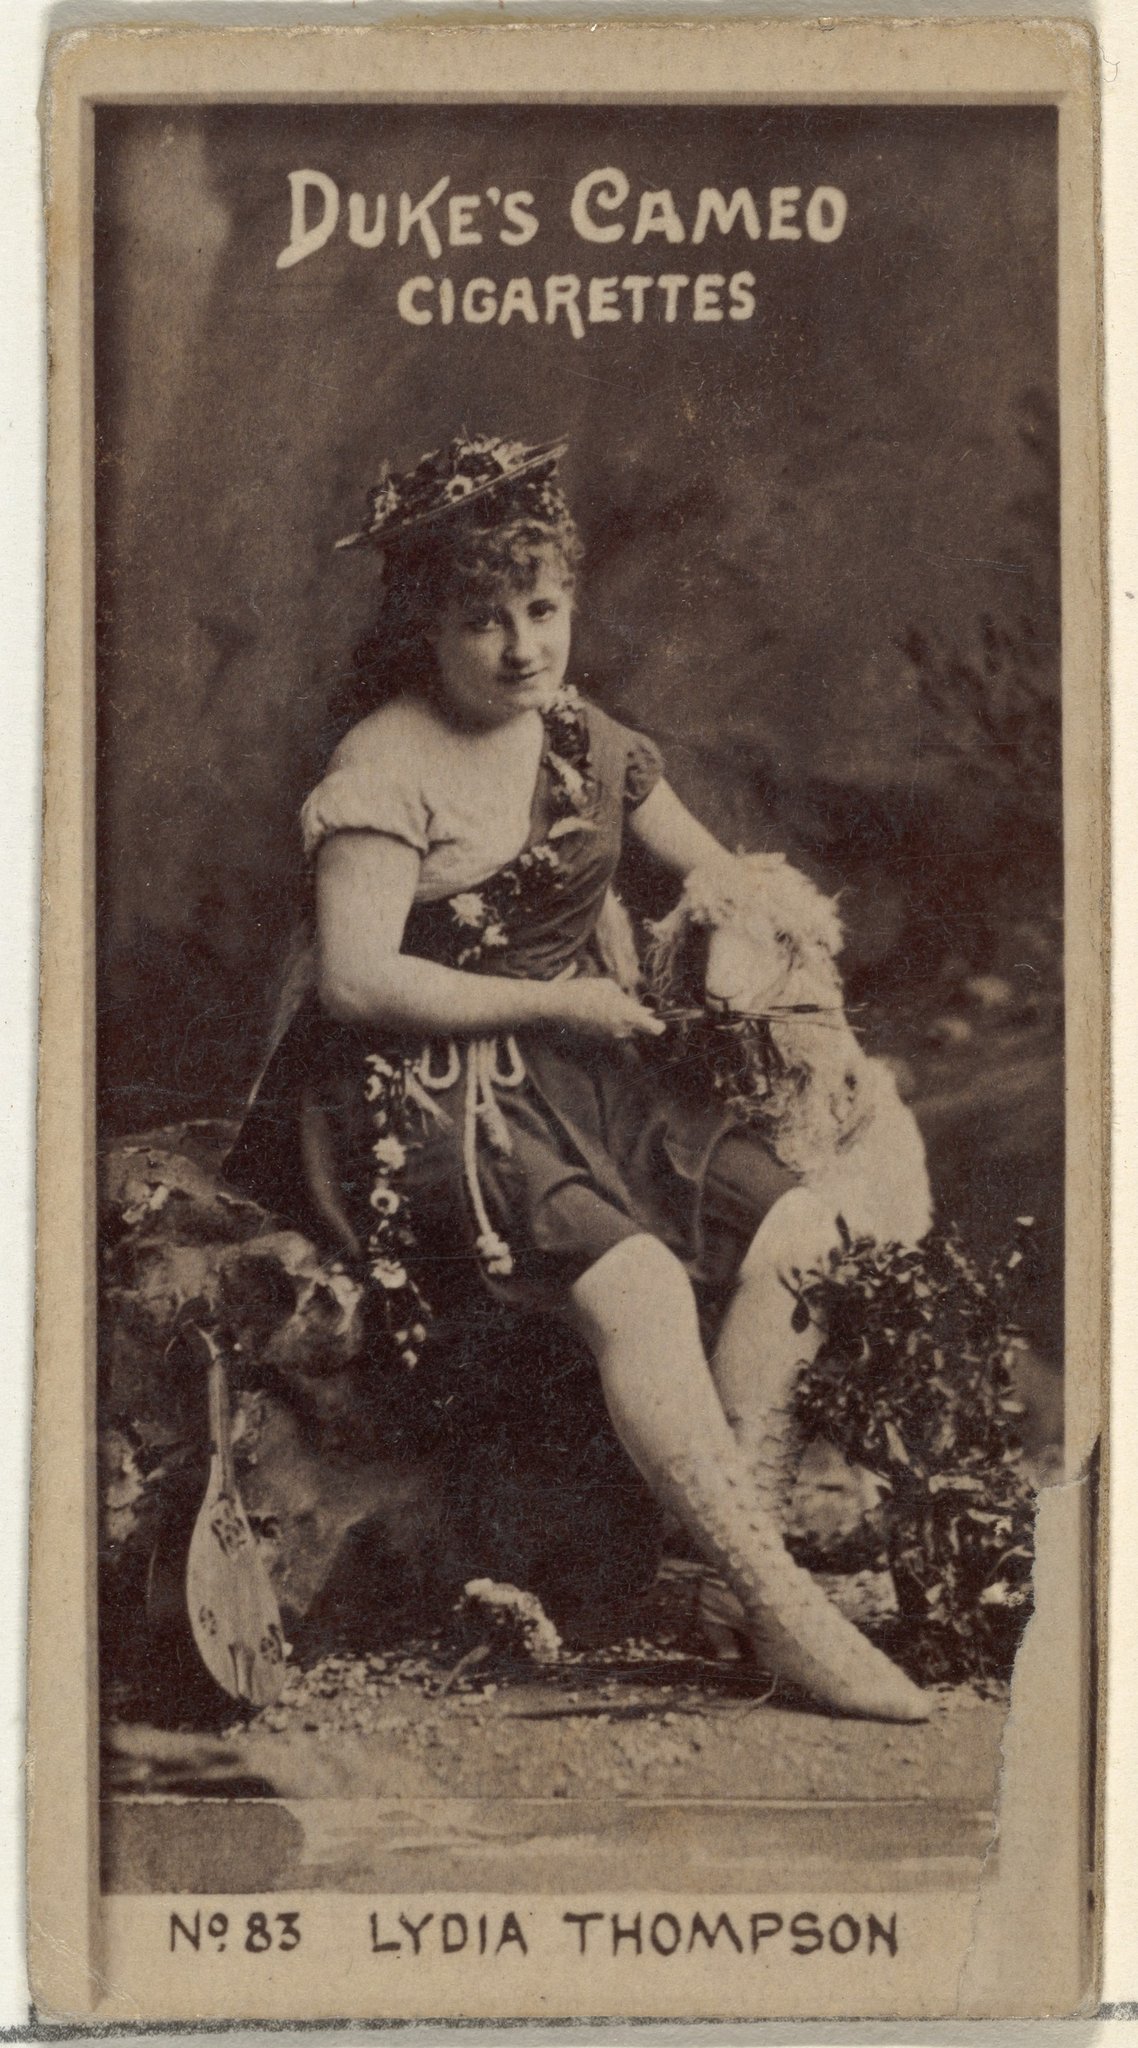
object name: photograph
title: Card Number 83, Lydia Thompson, from the Actors and Actresses series (N145-4) issued by Duke Sons & Co. to promote Cameo Cigarettes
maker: w. duke, sons & co.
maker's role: publisher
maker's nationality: american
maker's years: 1870-1920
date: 1880-1889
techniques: albumen silver print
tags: portraits,women,sheep,actresses